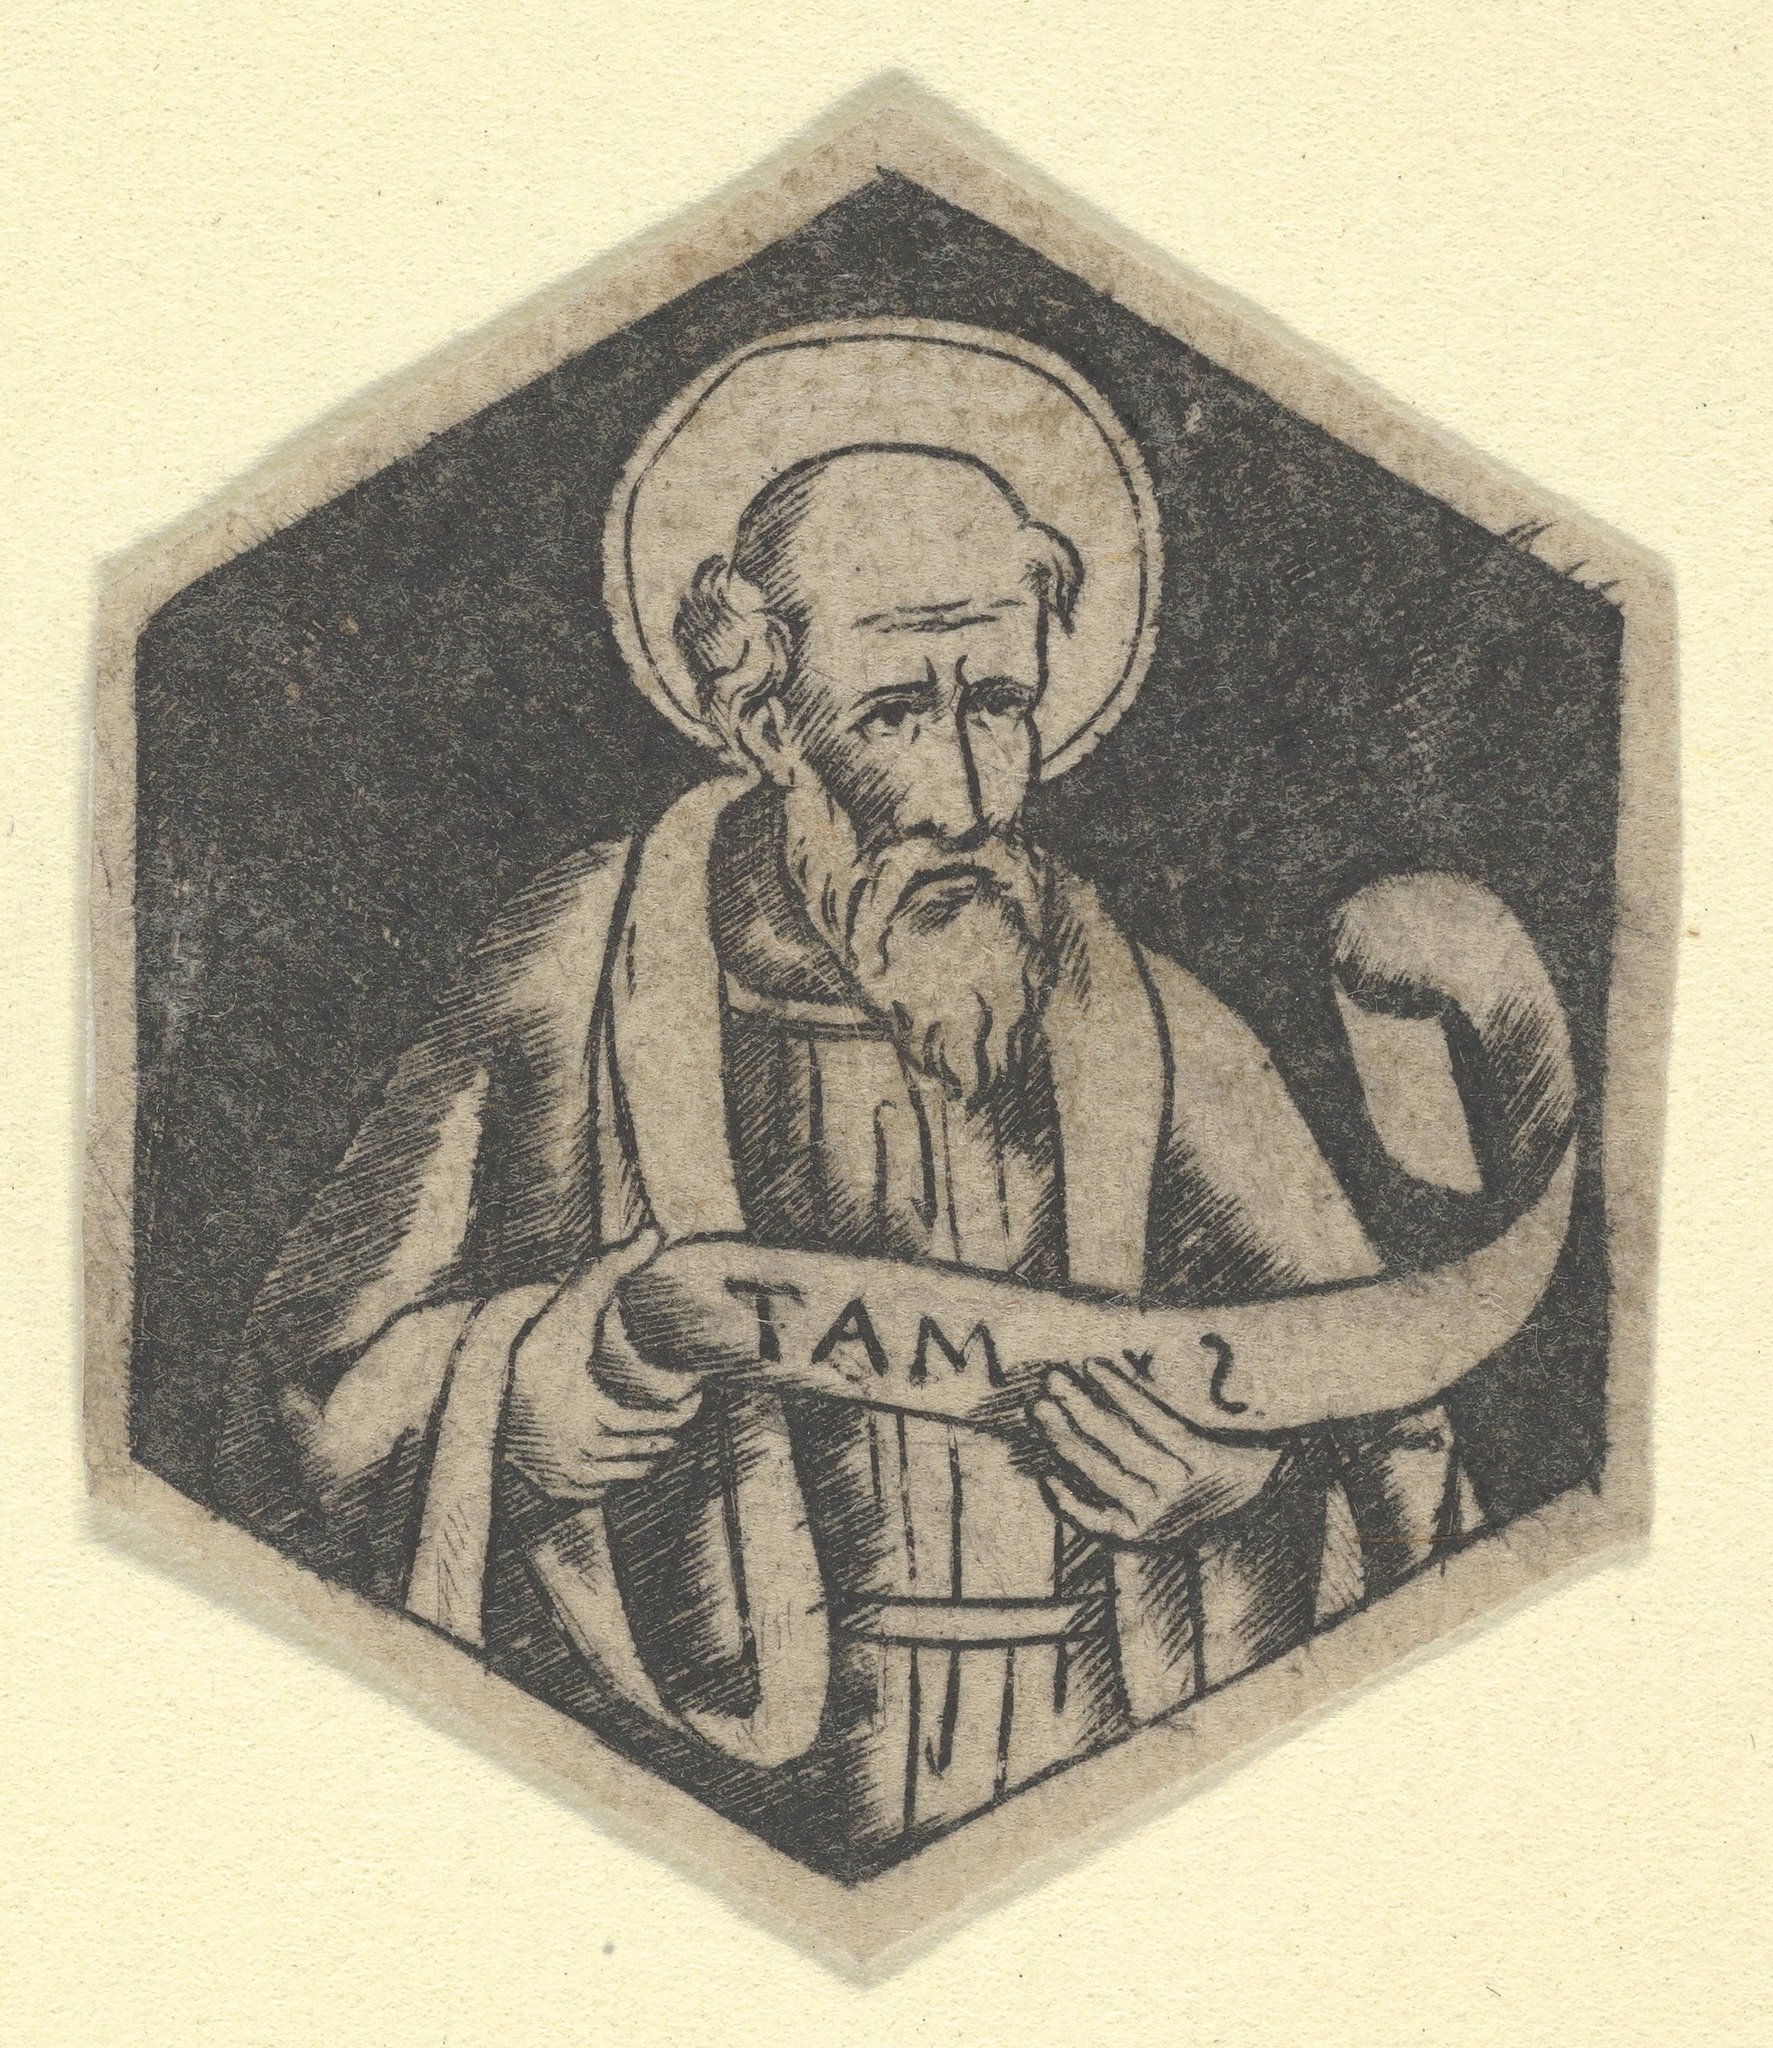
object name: print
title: St Matthew the Evangelist, holding a banderole (possibly a modern impression)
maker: Anonymous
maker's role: artist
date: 1480-1520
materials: niello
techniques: engraving, printing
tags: saint matthew,flags